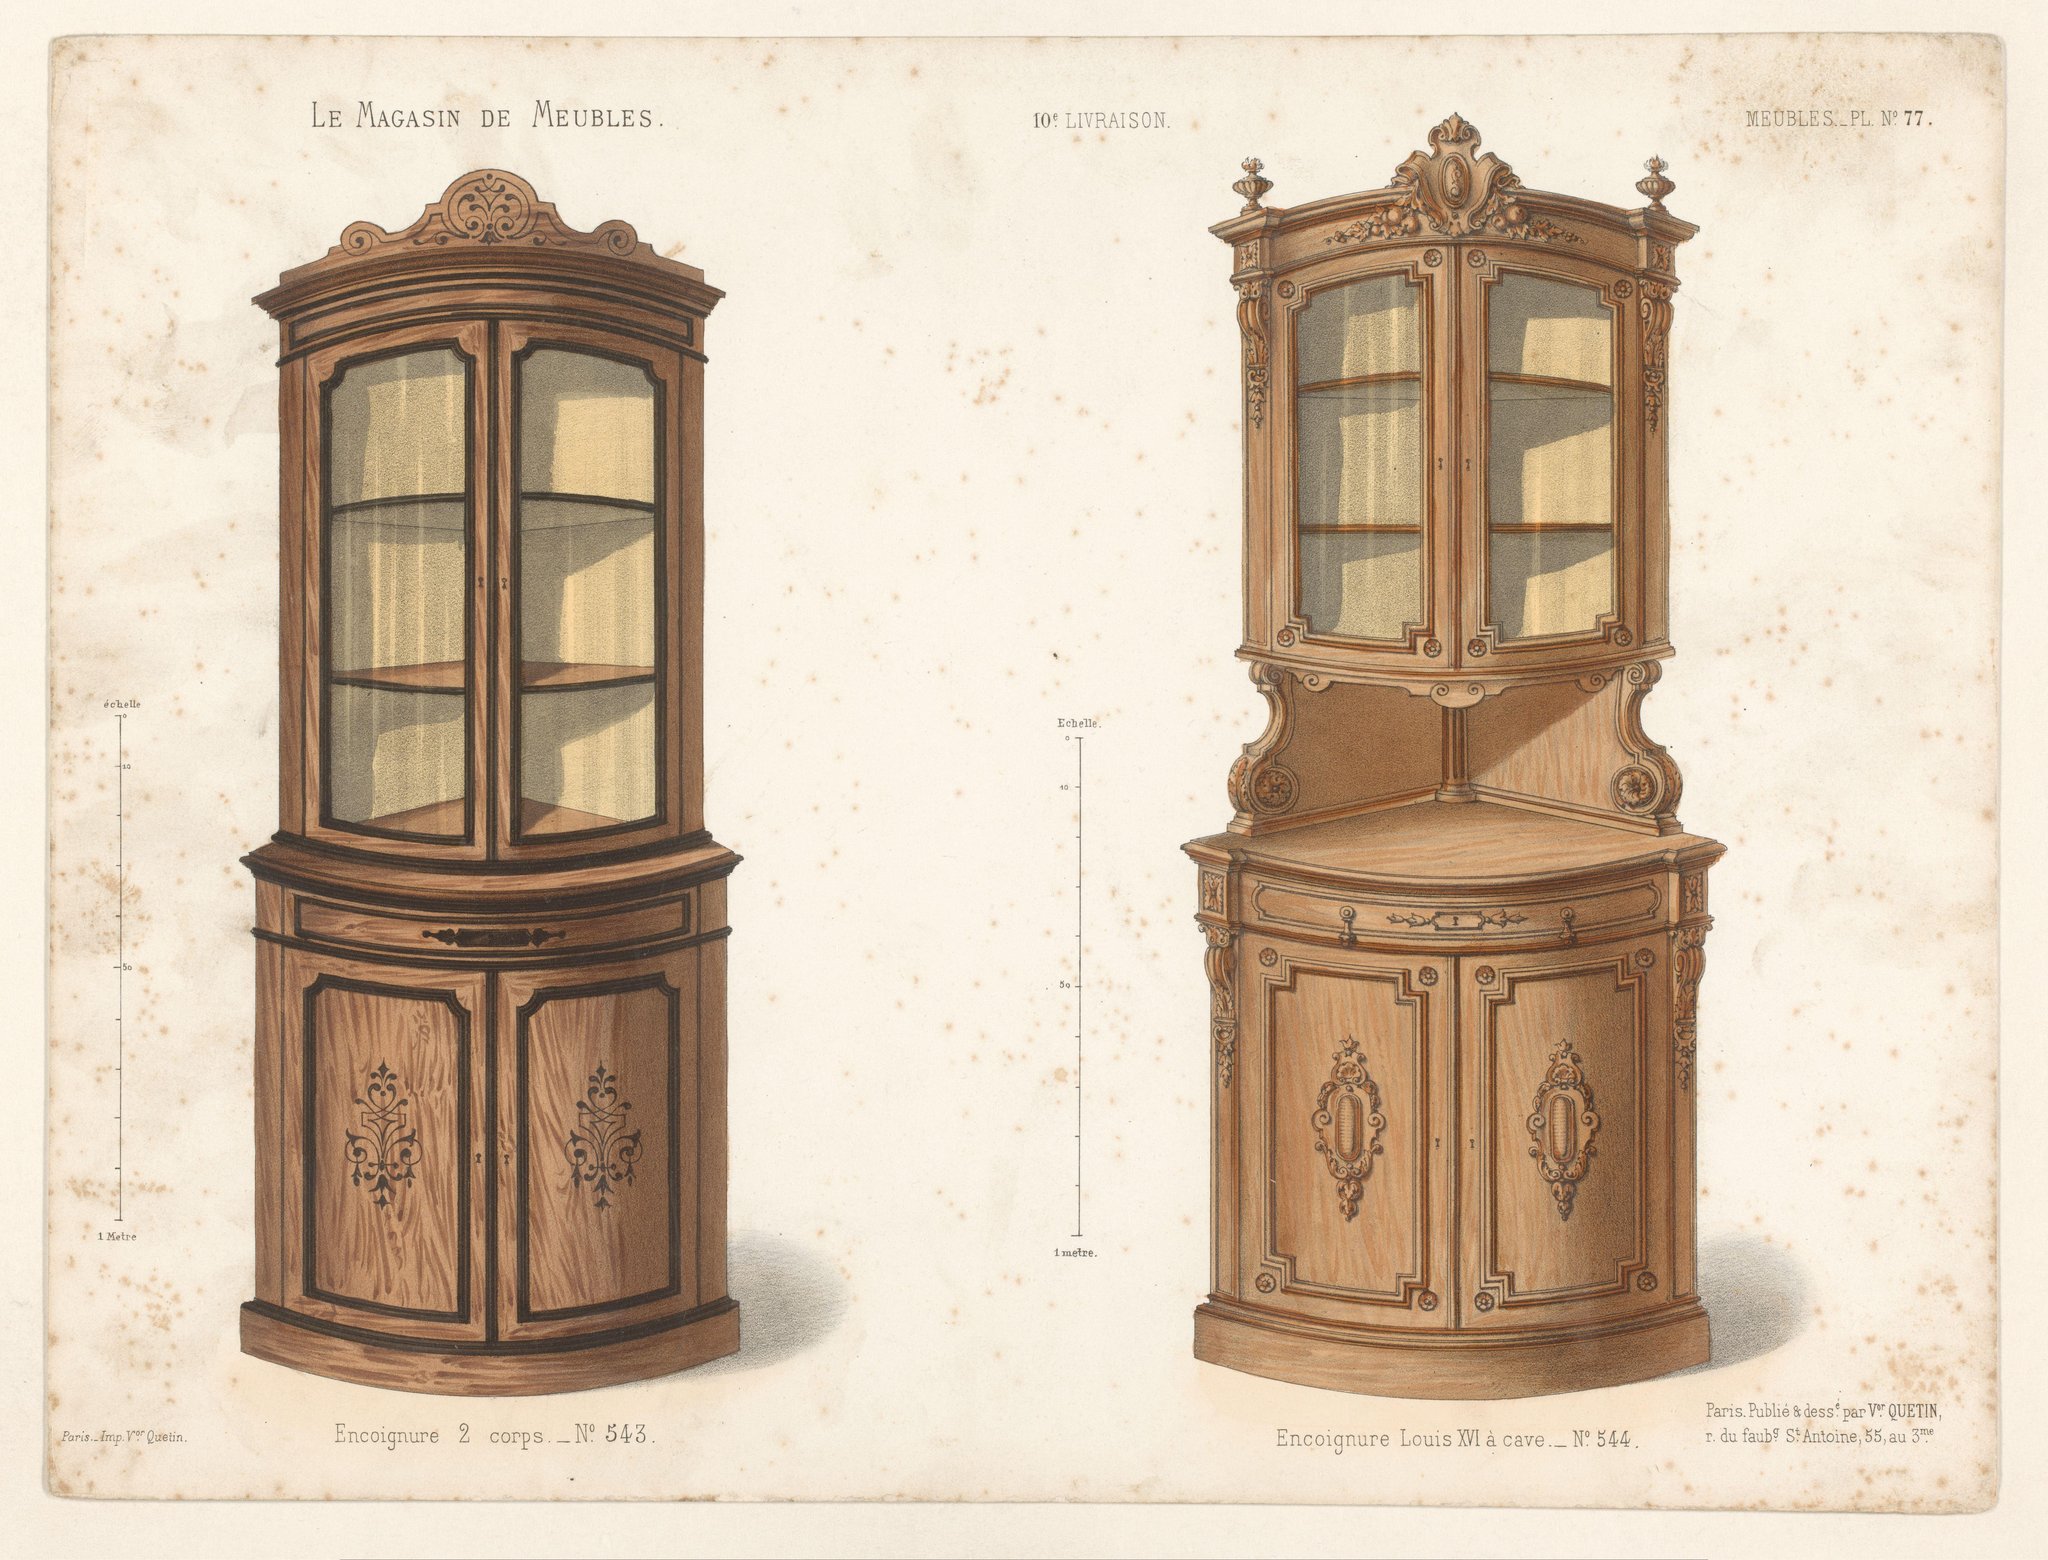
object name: print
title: Twee hoekkasten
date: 1832-1877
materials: paper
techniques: hand coloring, lithograph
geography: paris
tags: furniture for storage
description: Twee hoekkasten, één in de Lodewijk XVI-stijl. Prent uit 10e Livraison.